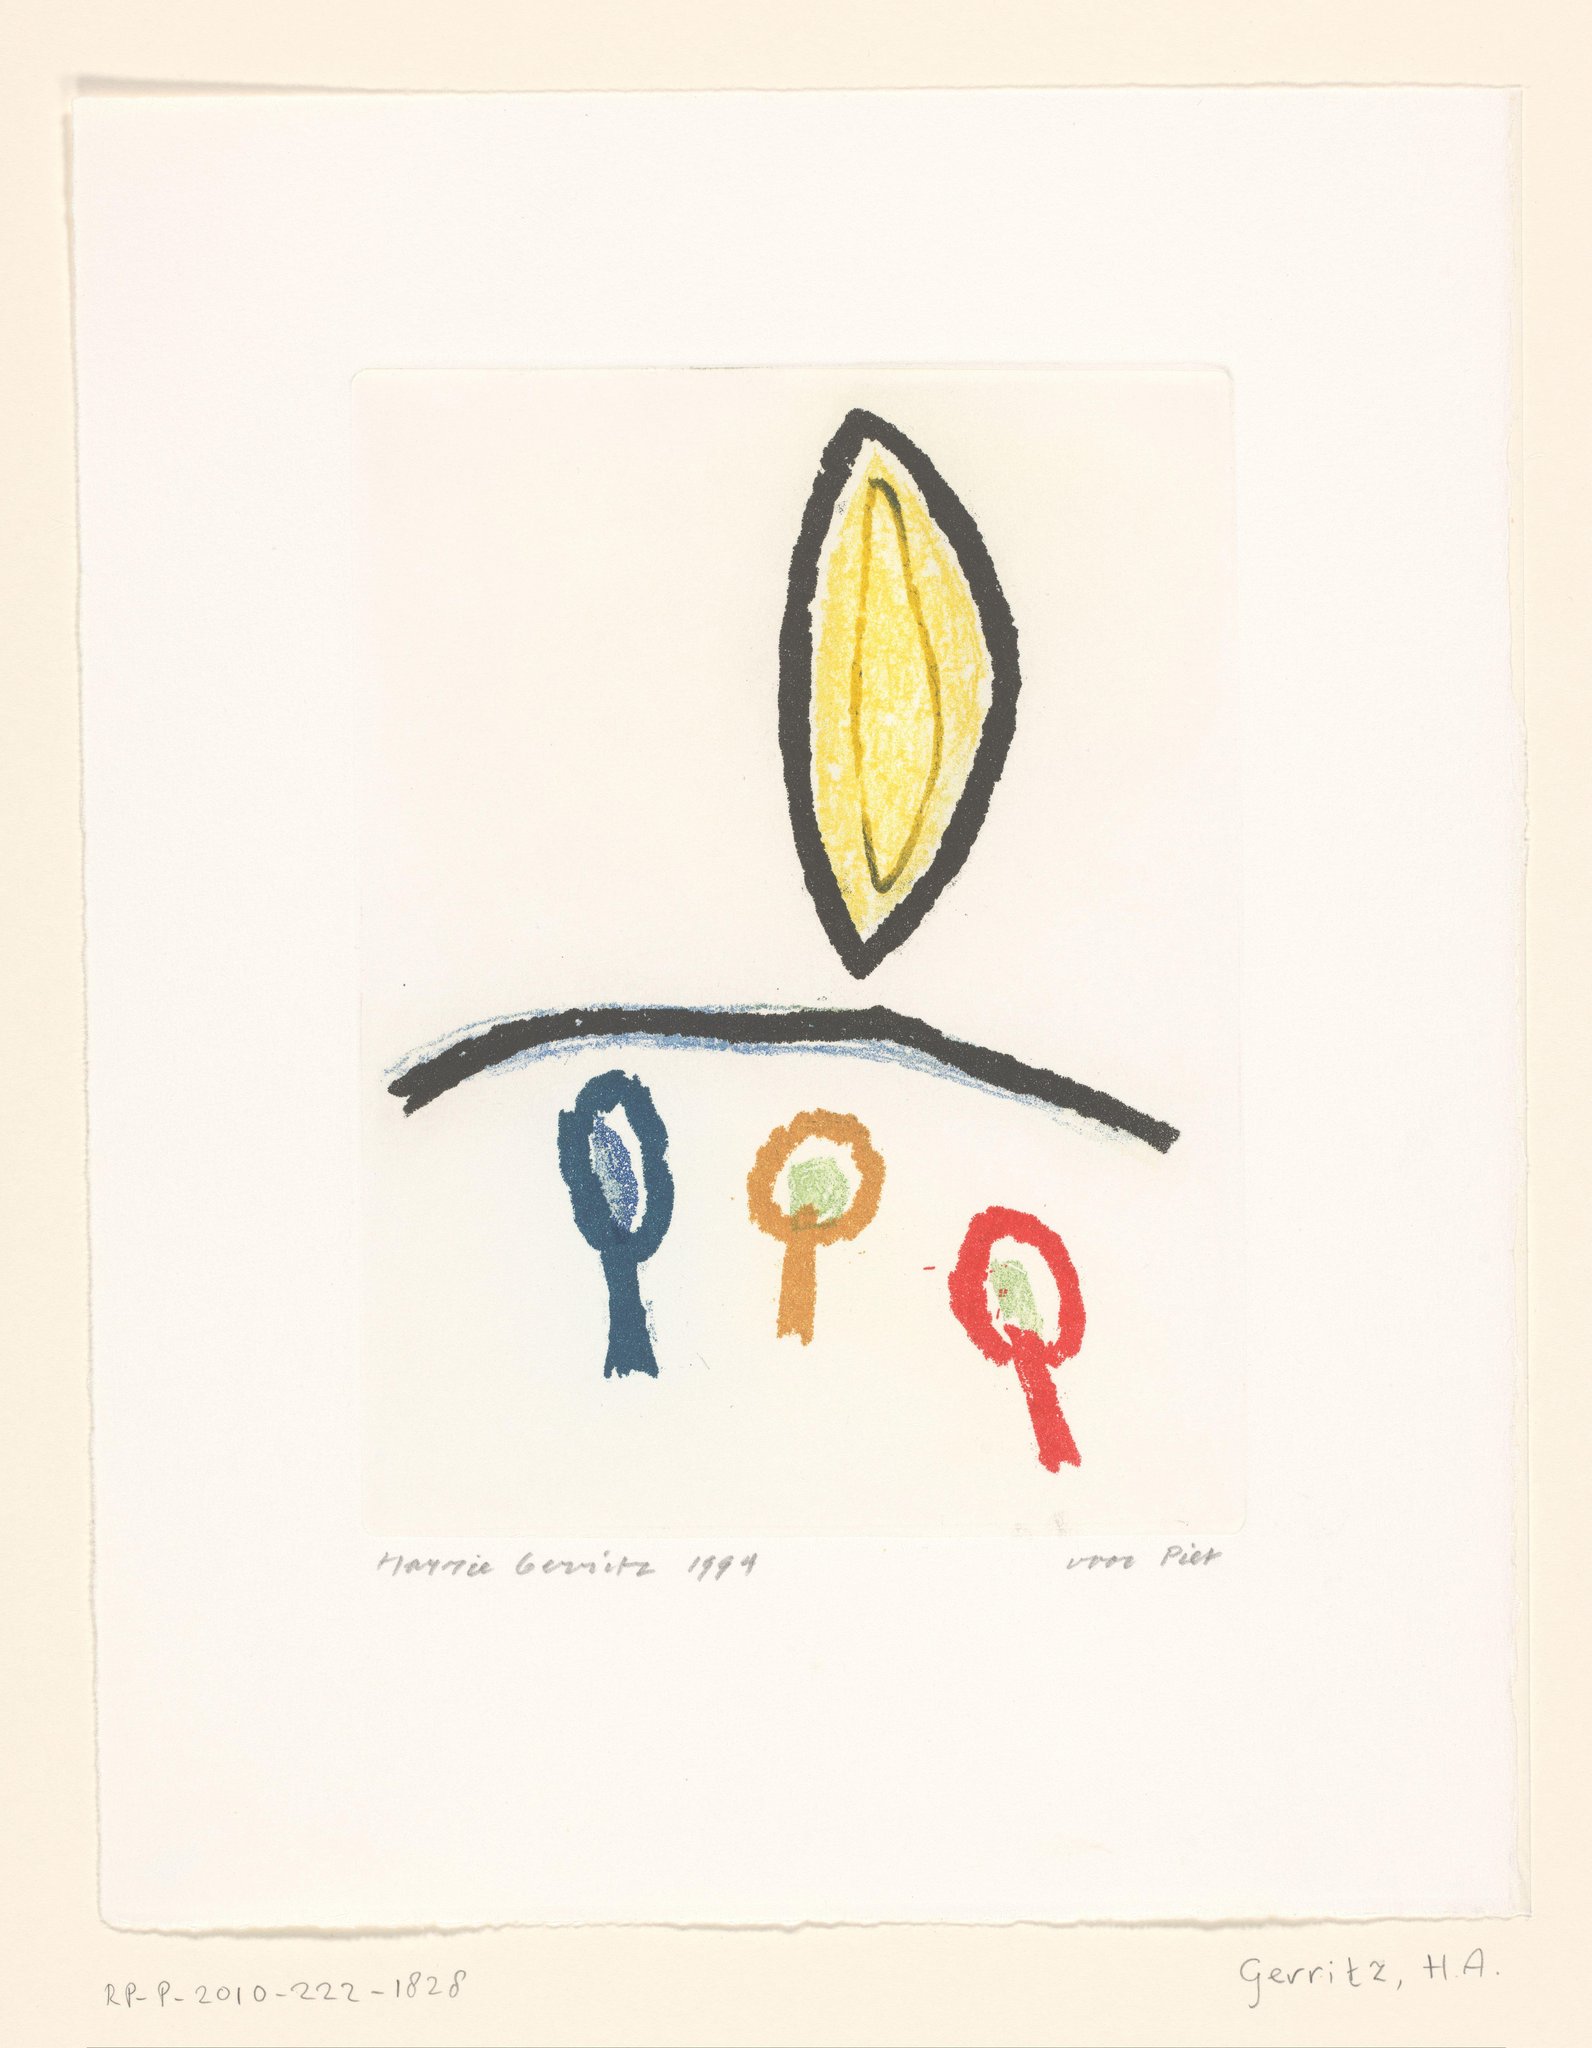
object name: print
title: Drie gekleurde bomen, gele ellips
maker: harrie a. gerritz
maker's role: draughtsman, painter, print maker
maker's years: 1940-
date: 1994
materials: paper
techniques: aquatint, soft ground etching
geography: amsterdam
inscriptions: signature and date: ‘Harrie Gerritz 1994’